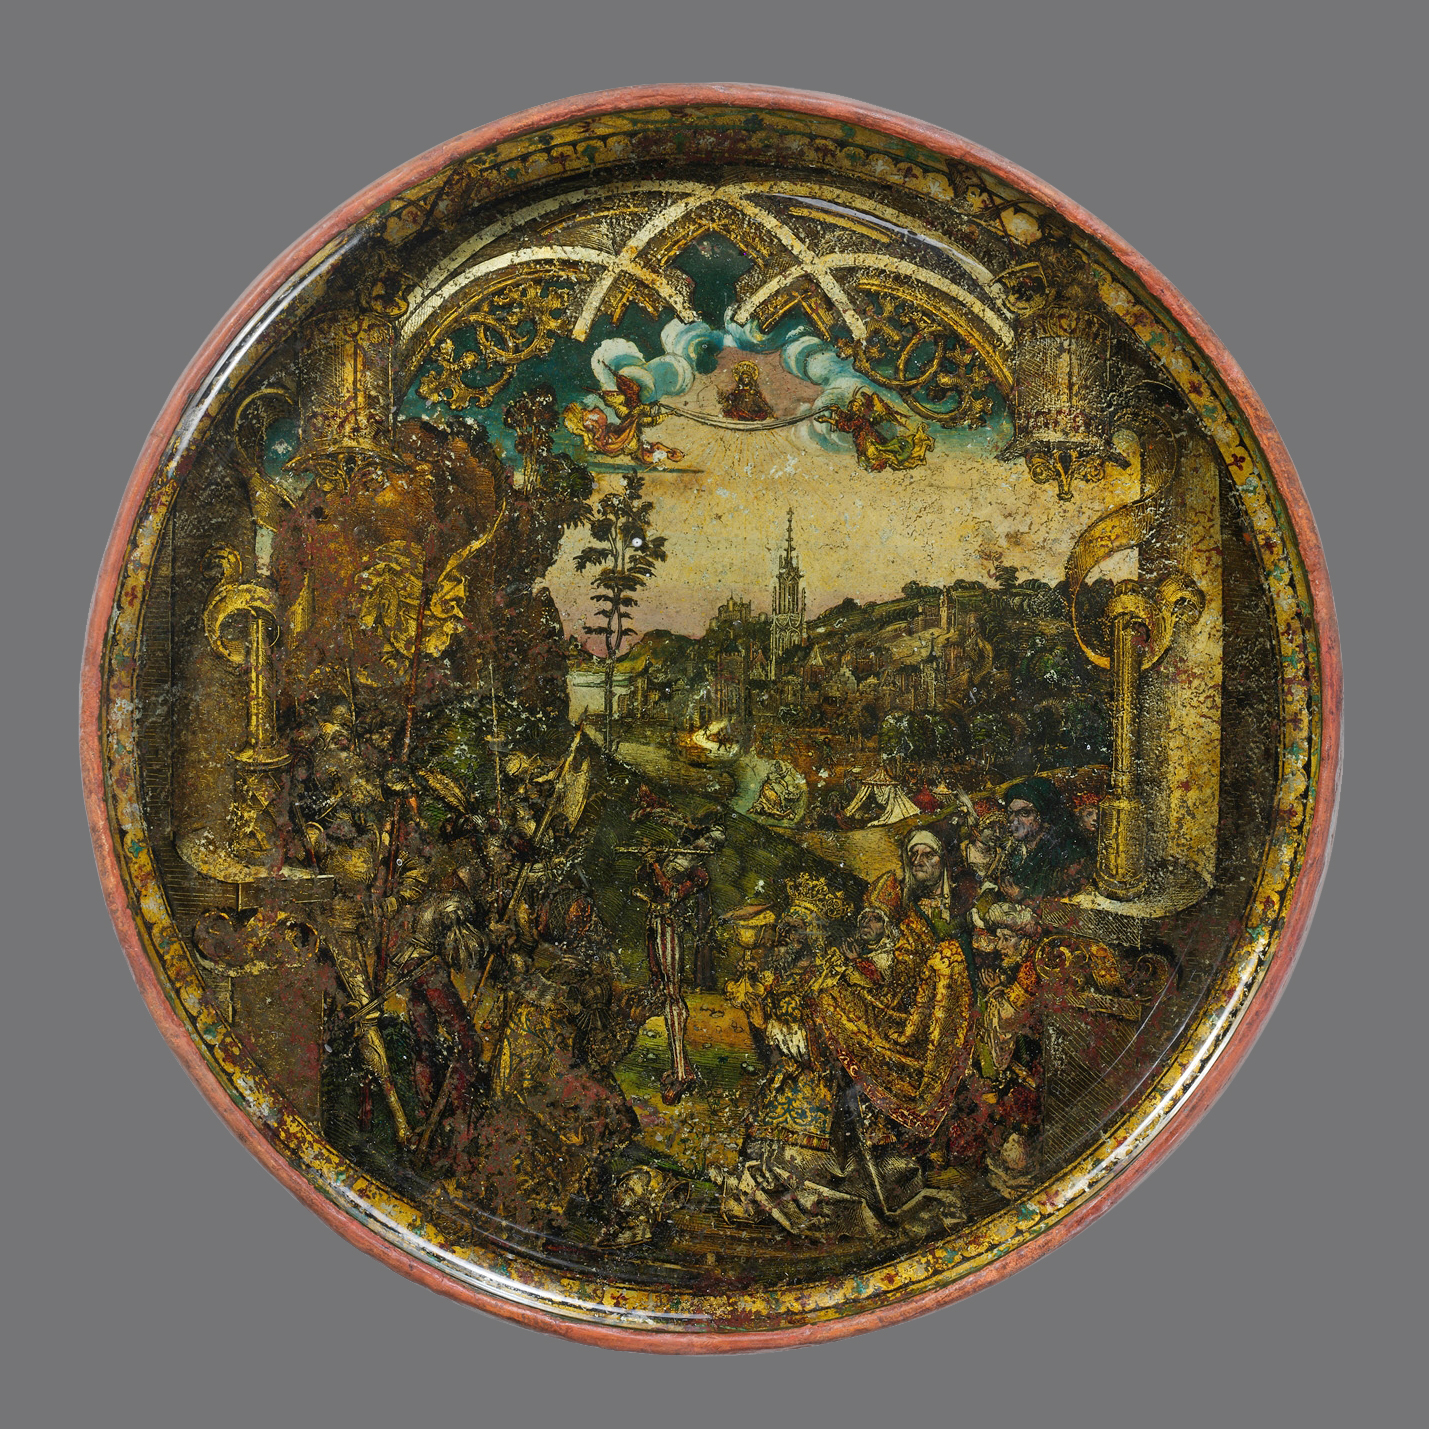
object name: dish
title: Dish with Abraham and Melchizedek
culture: german, south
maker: hans of landshut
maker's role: artist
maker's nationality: german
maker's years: 1400-1550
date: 1498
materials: paint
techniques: glassblowing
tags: kings,abraham